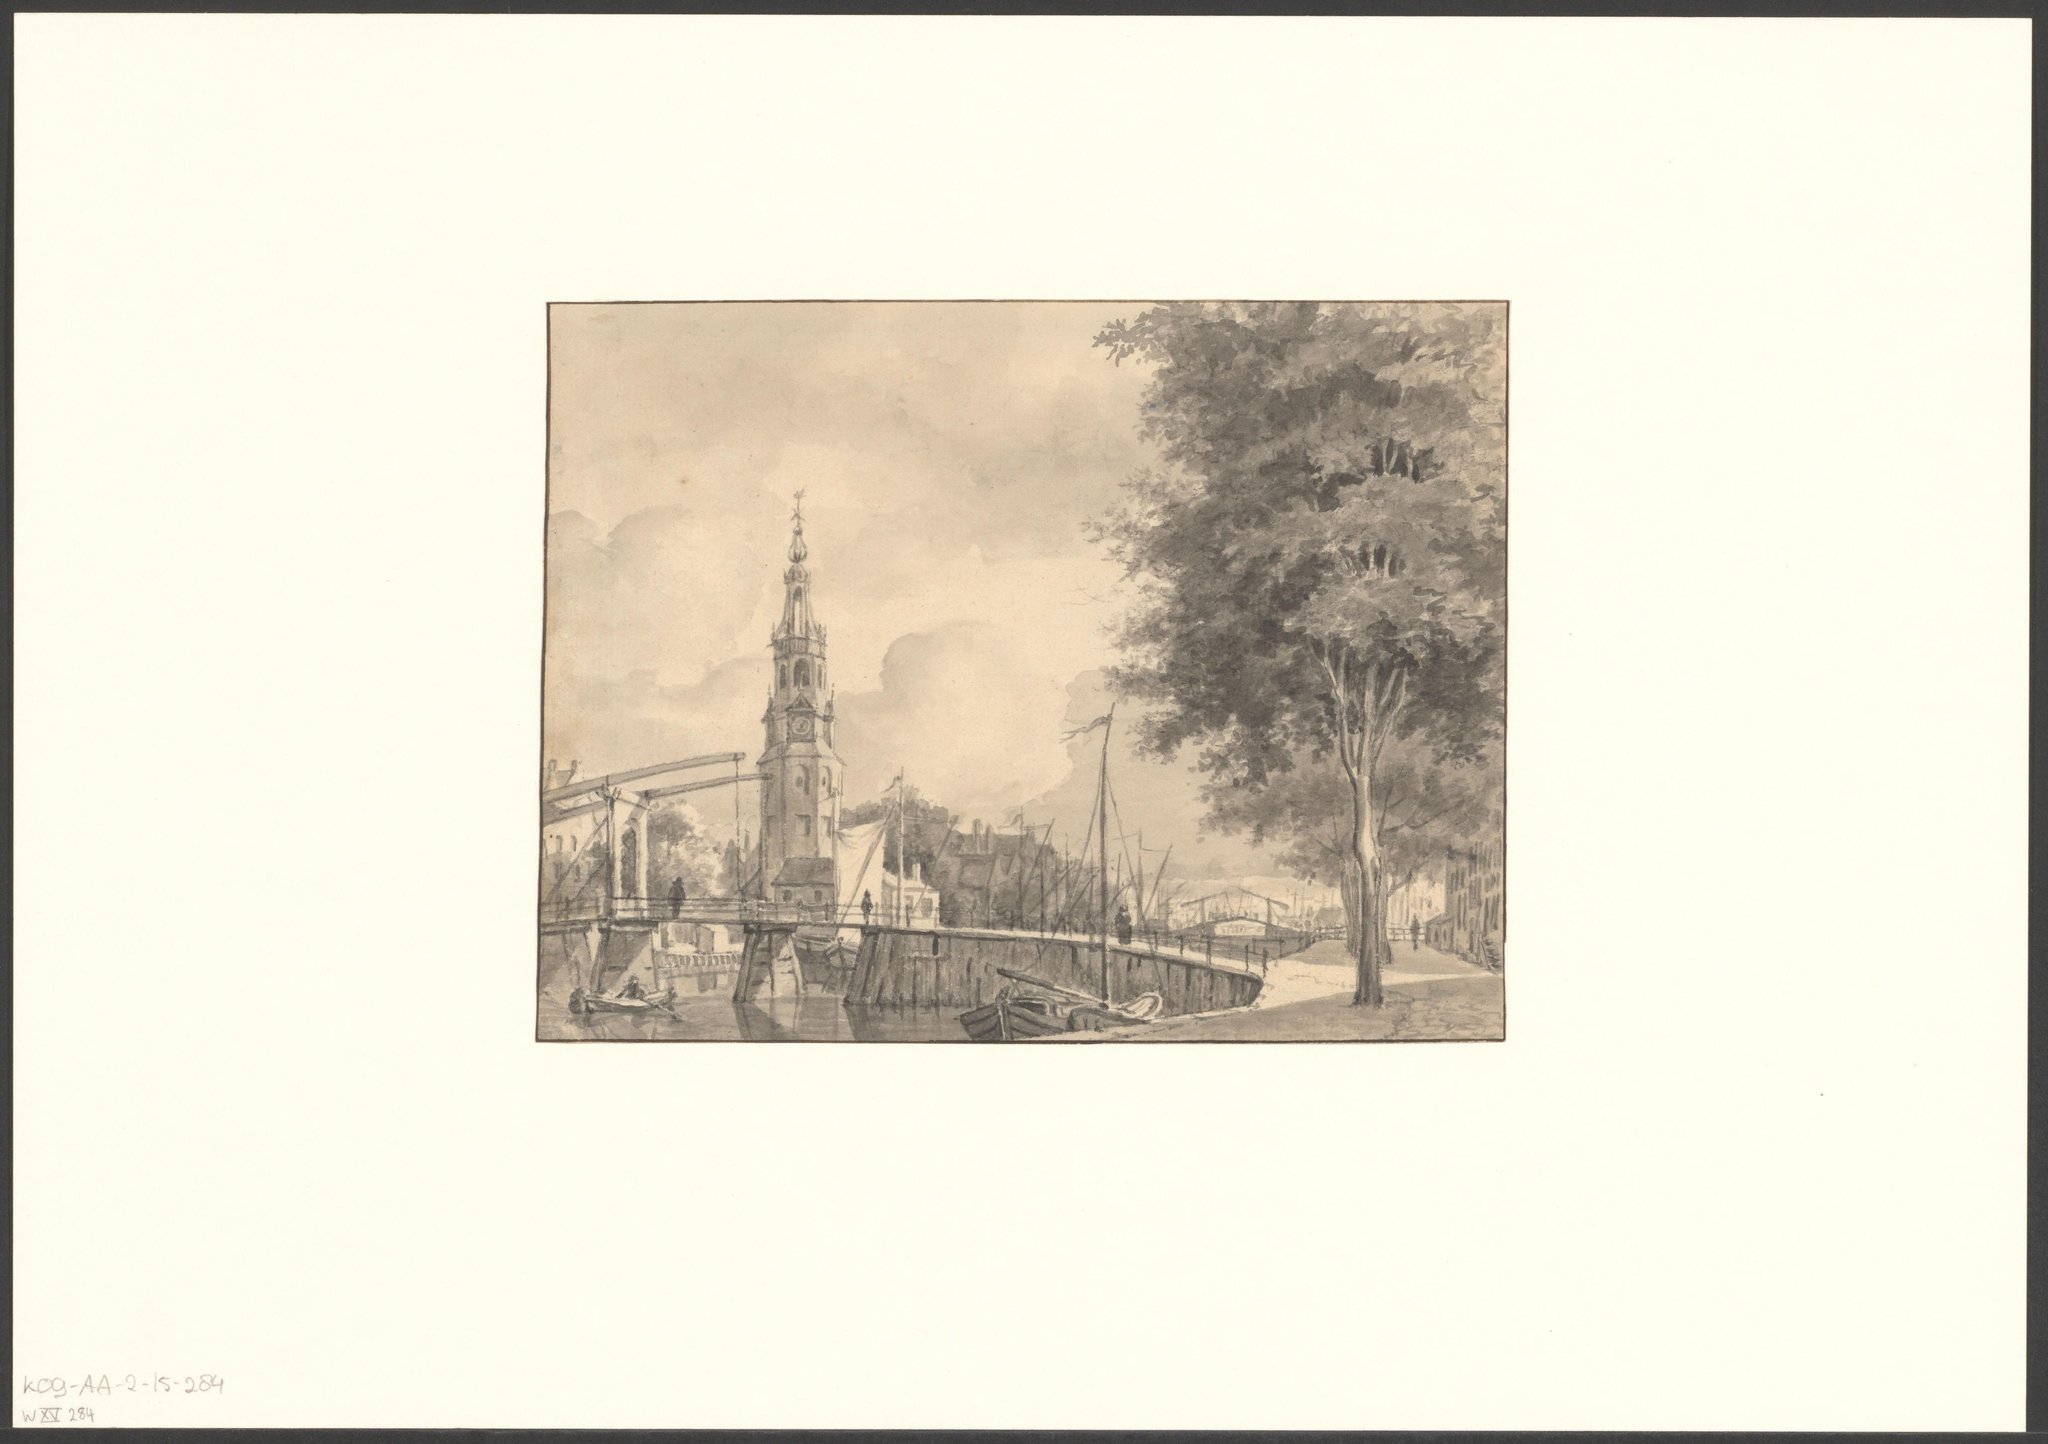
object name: drawing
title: Gezicht op de Oudeschans, de kalkmarkt en de Montelbaanstoren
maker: gerrit lamberts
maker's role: bookseller, draughtsman, print maker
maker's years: 1776-1850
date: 1824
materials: paper, pencil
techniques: brush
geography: amsterdam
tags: sailing-ship, sailing-boat, tower, clock tower ~ monumental adornment, city-view in general; 'veduta', canal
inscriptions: collector's mark: Lugt 800a, inscription: ‘uit de [...]gann[...] / van d[...]l[...] J[...]llet. / De oude schans Montelbaanstorens’, signature and date: ‘G: Lamberts / 1824.’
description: Tekening binnen de Atlas Van Eck ingedeeld op wijknummer 15.